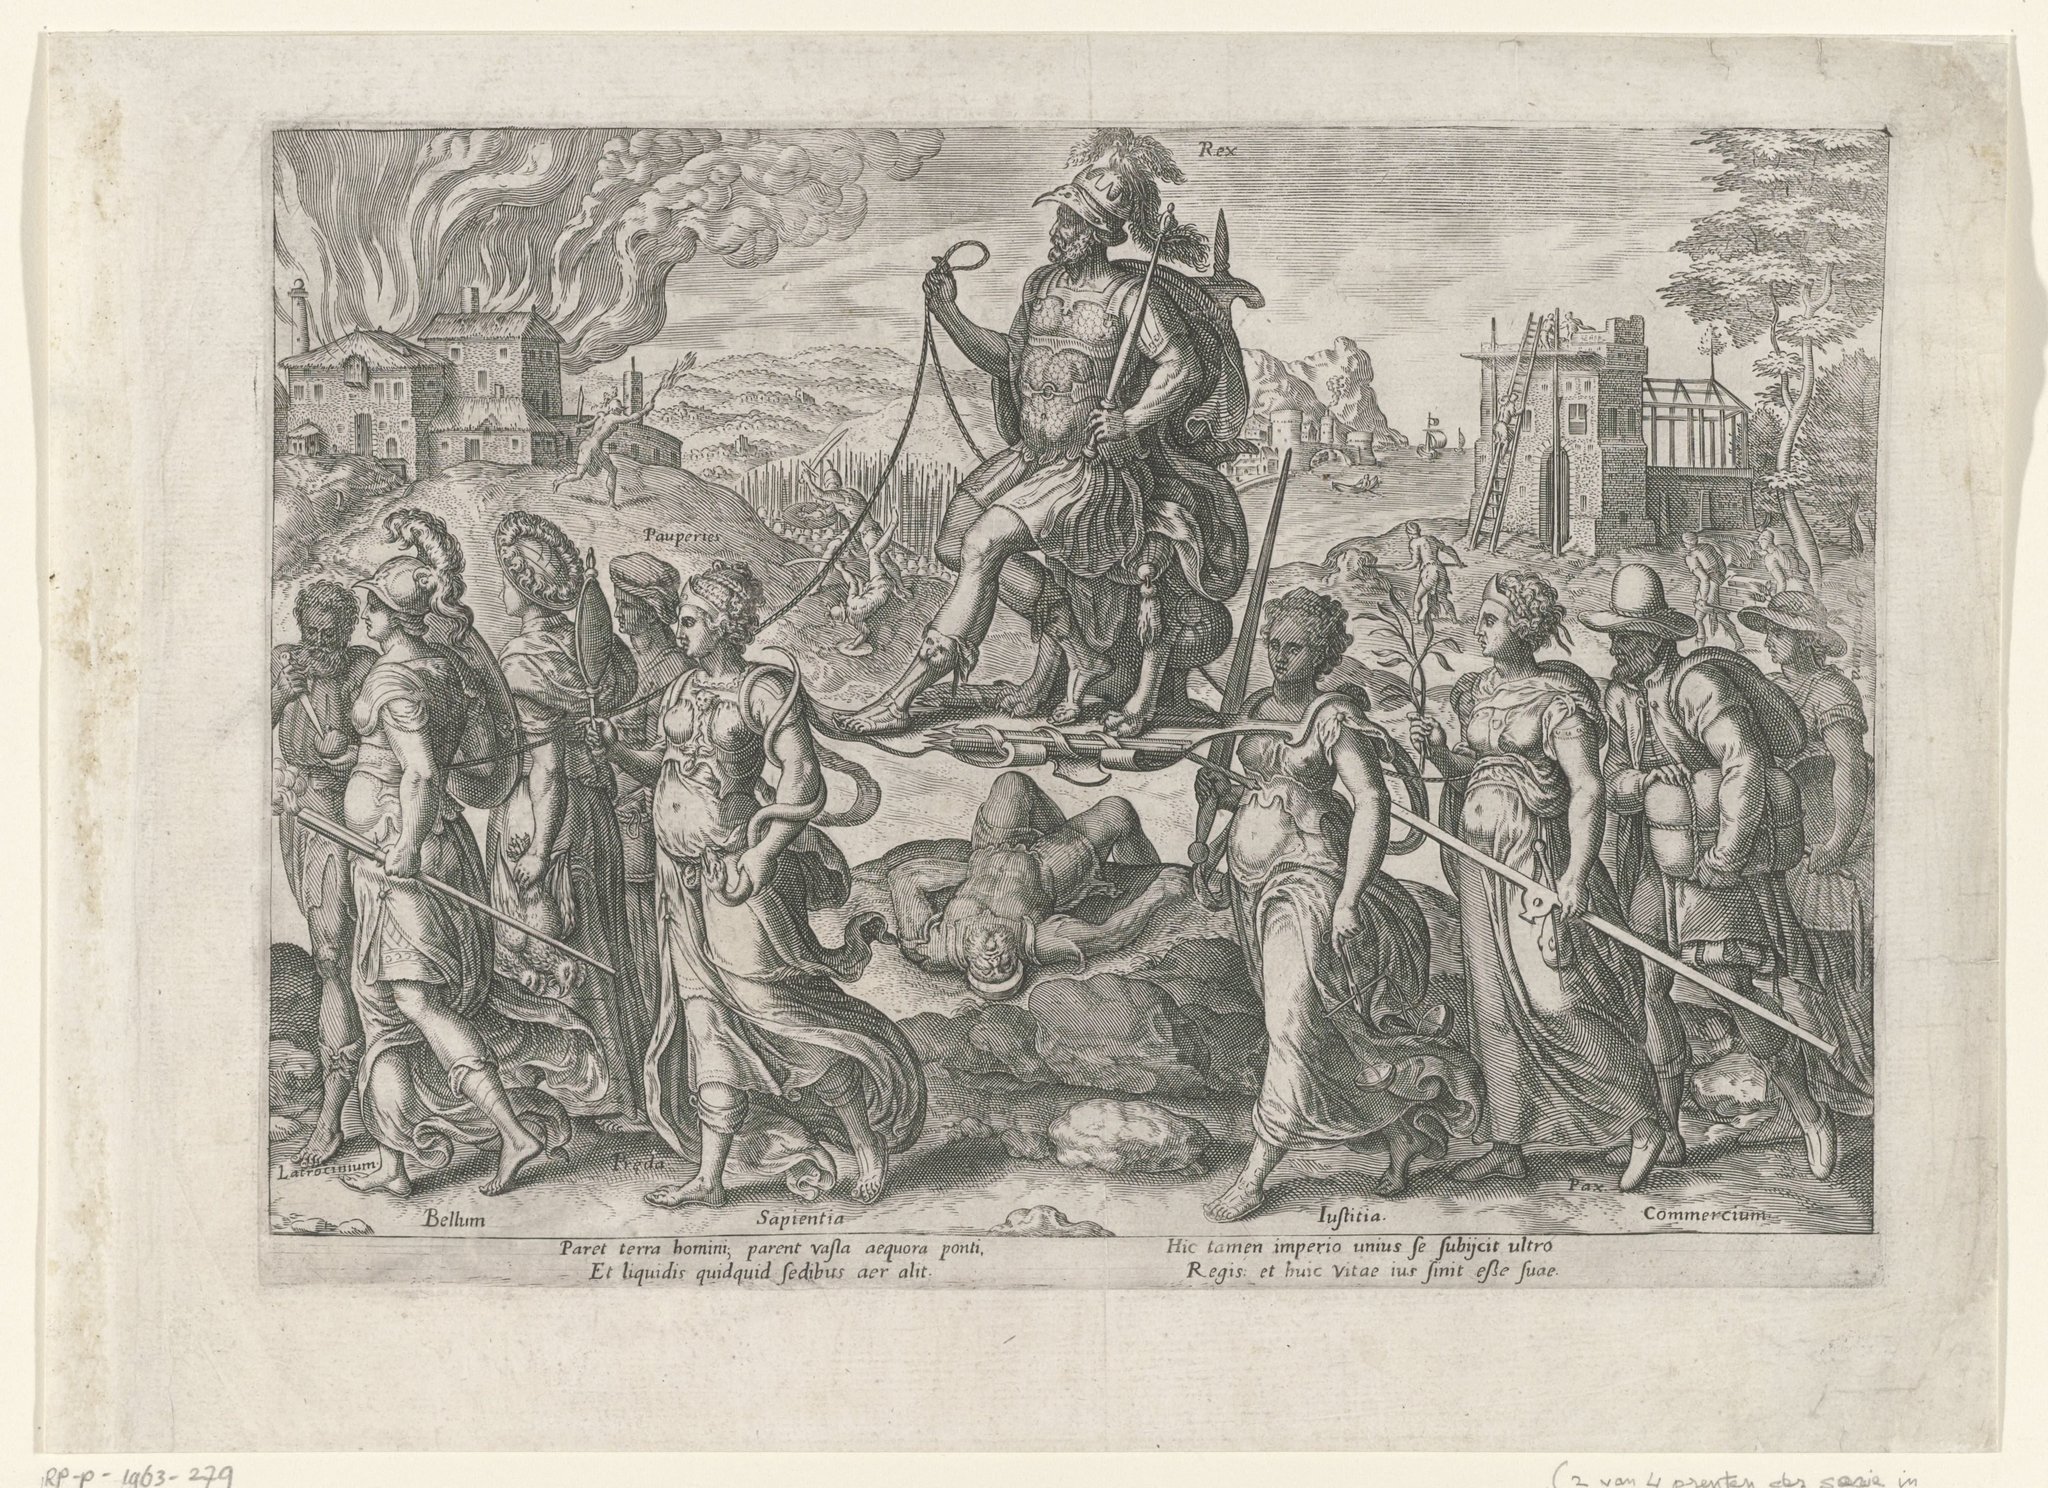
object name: print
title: Triomfen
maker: Anonymous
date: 1564-1600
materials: paper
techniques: engraving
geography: low countries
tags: justice, 'justitia'; 'giustitia divina' (ripa) ~ one of the four cardinal virtues, symbols, allegories of peace, 'pax'; 'pace' (ripa), wisdom; 'sapienza', 'sapienza humana', 'sapienza vera' (ripa), triumphs (allegorical and symbolic), symbols, allegories of war; 'guerra' (ripa), king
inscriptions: collector's mark: Lugt 2228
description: Een koning wordt in triomf gedragen door Wijsheid en Rechtvaardigheid. Voorop in de stoet lopen Diefstal, Oorlog, Buit en Armoede. In het landschap wordt gevochten en huizen staan in brand. Achter de koning lopen Vrede, Handel en Landbouw. Op de achtergrond wordt gebouwd en het land bewerkt. Onder de voorstelling een vierregelig vers in het Latijn.